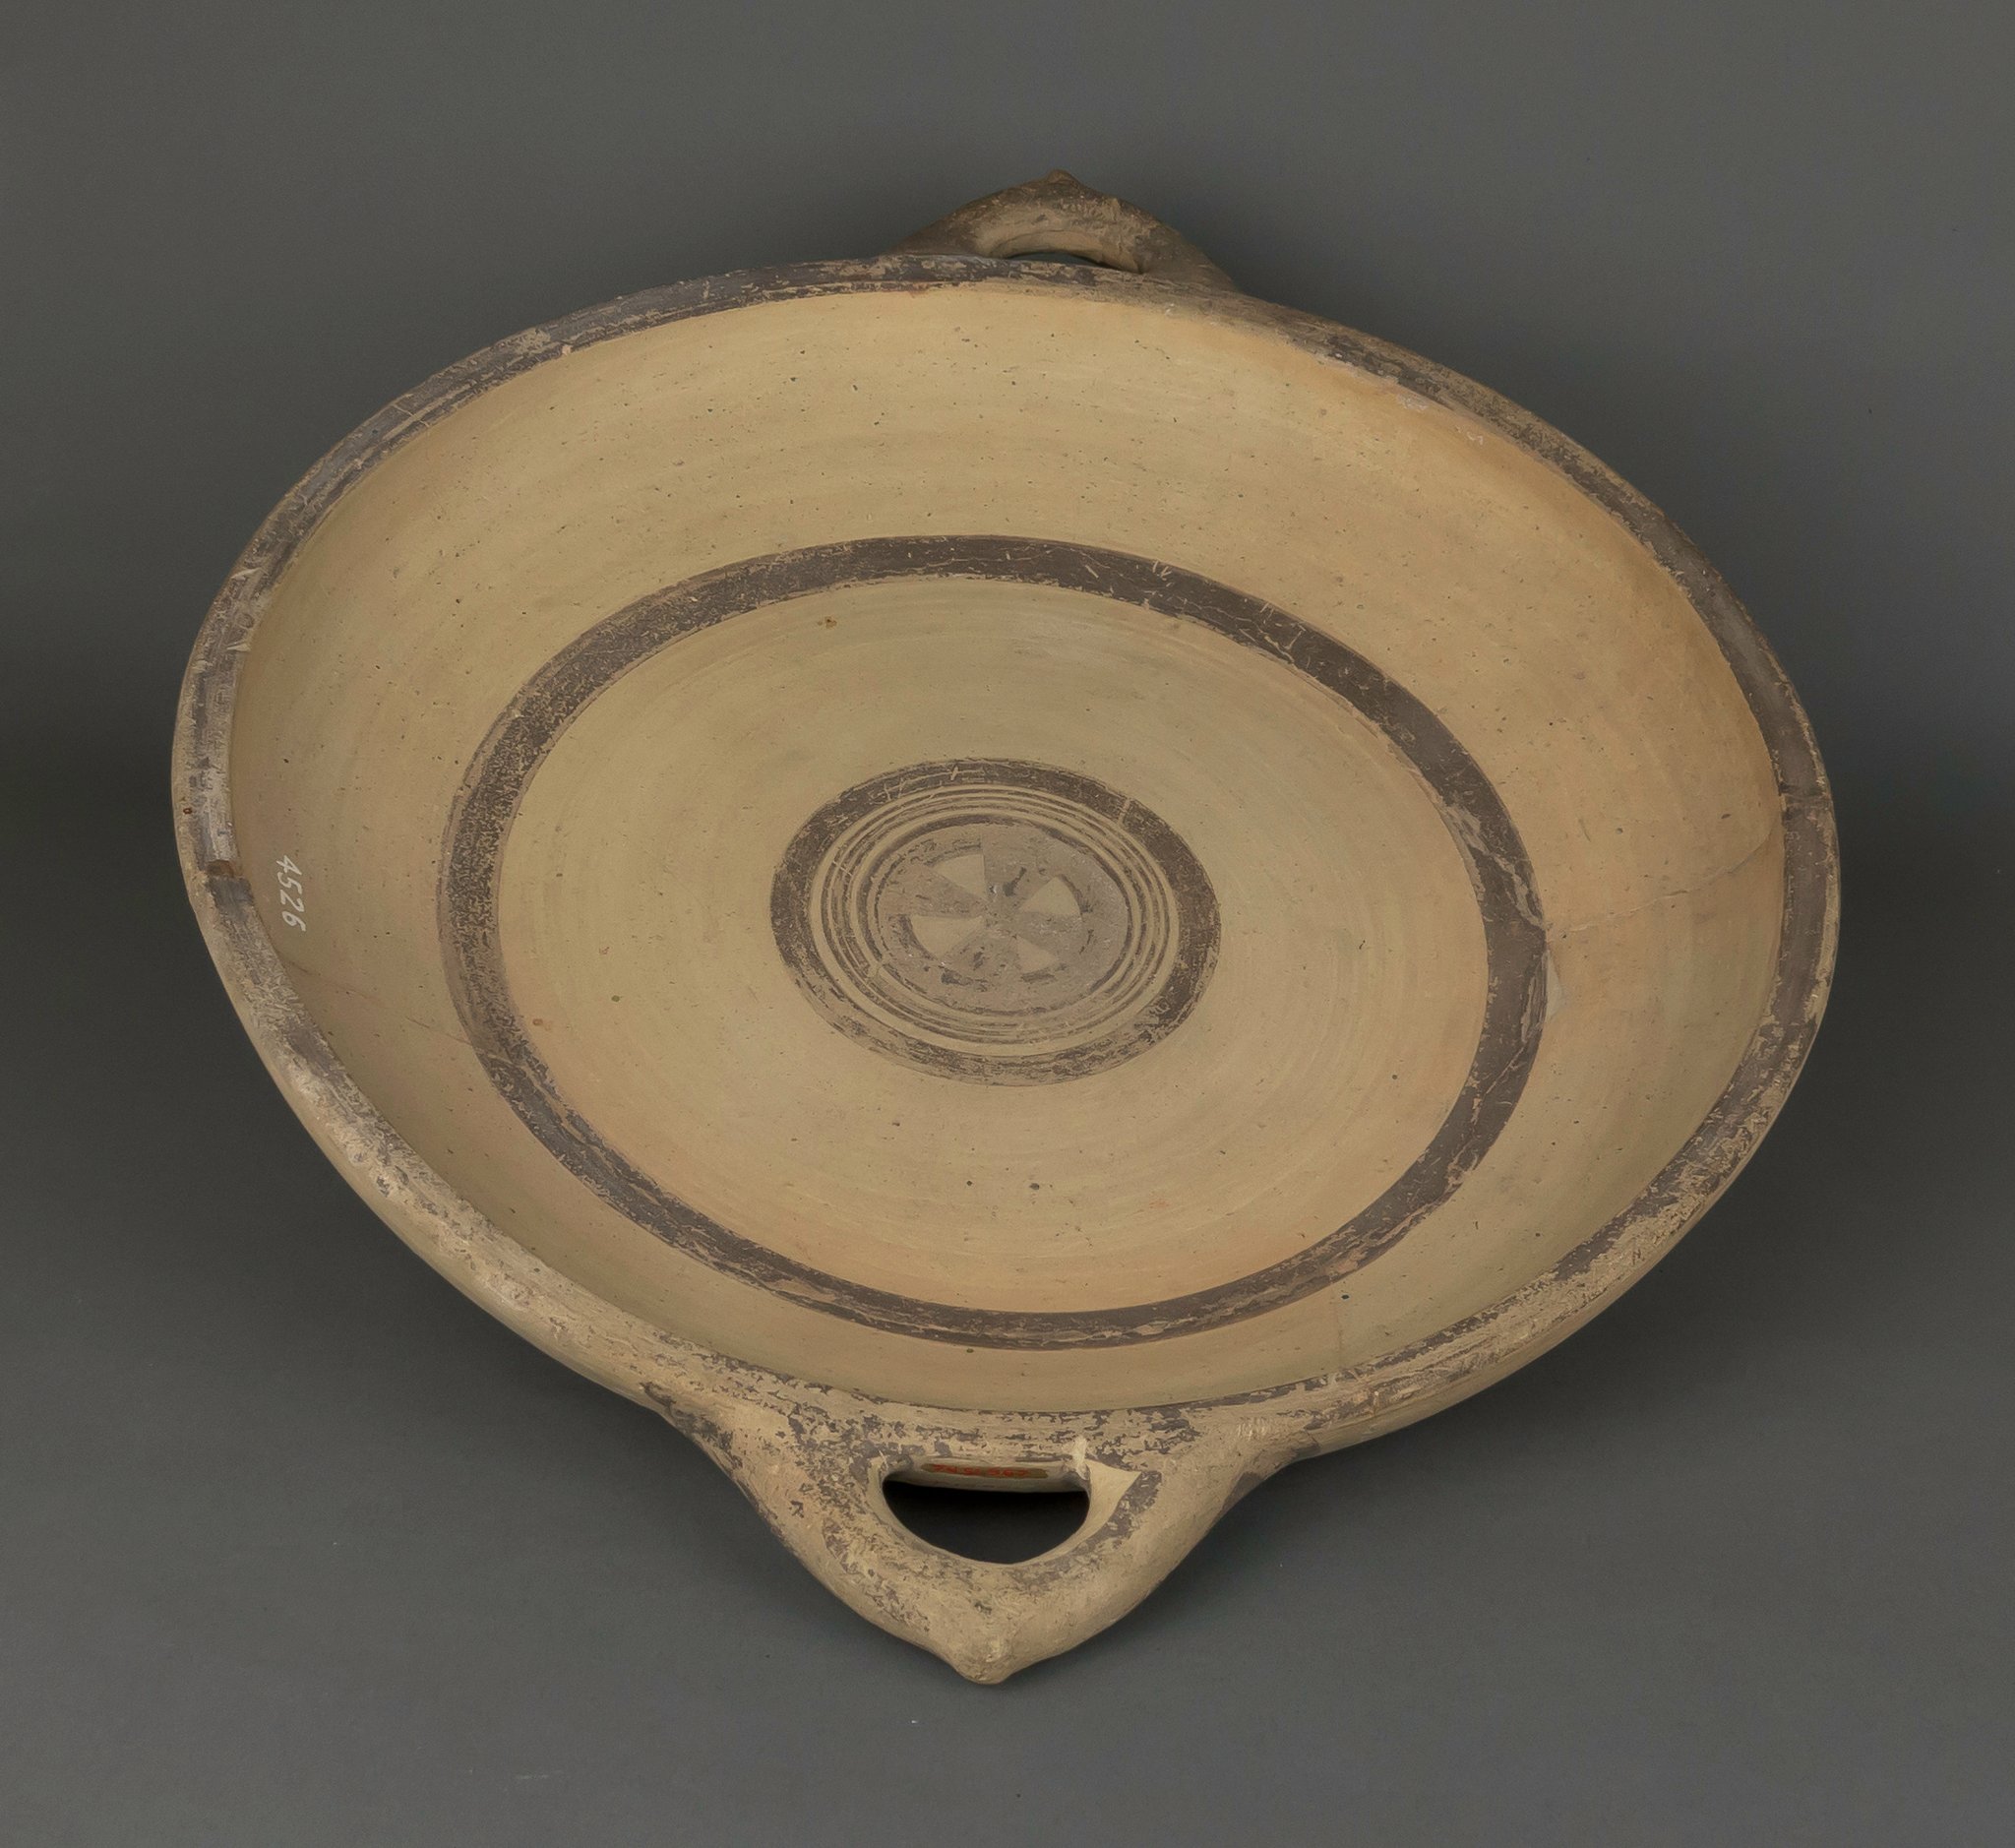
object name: plate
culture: cypriot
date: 1050-900 BCE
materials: terracotta